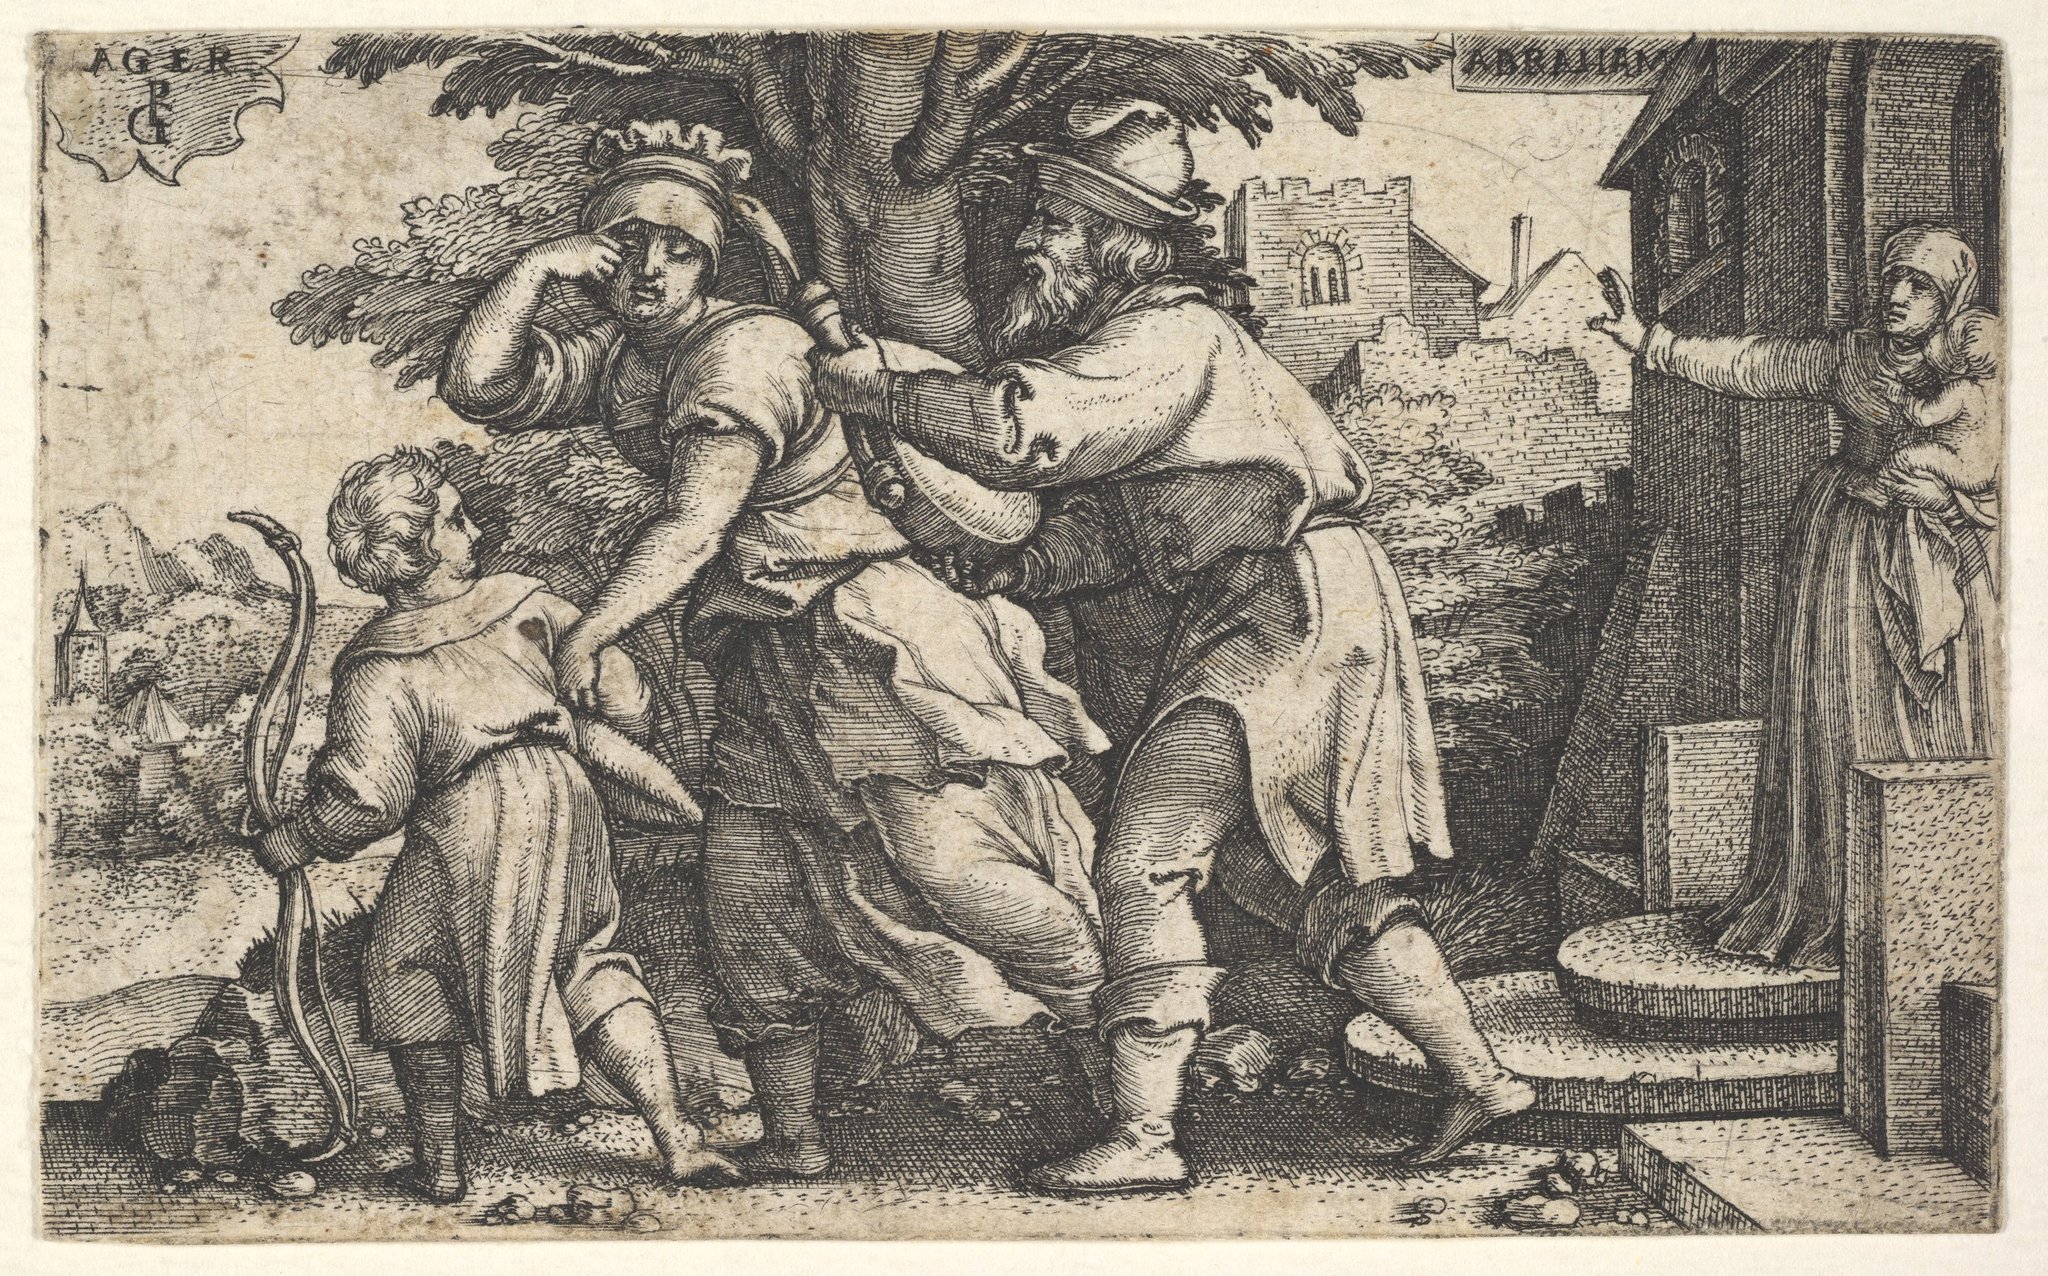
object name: print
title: Abraham sending away Hagar and Ishmael: Abraham holds forth a vessel as Hagar and Ishmael stride before him, from "The Story of Abraham"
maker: georg pencz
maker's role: artist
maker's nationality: german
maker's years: 1500-1550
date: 1543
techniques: engraving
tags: bow and arrow,infants,women,abraham